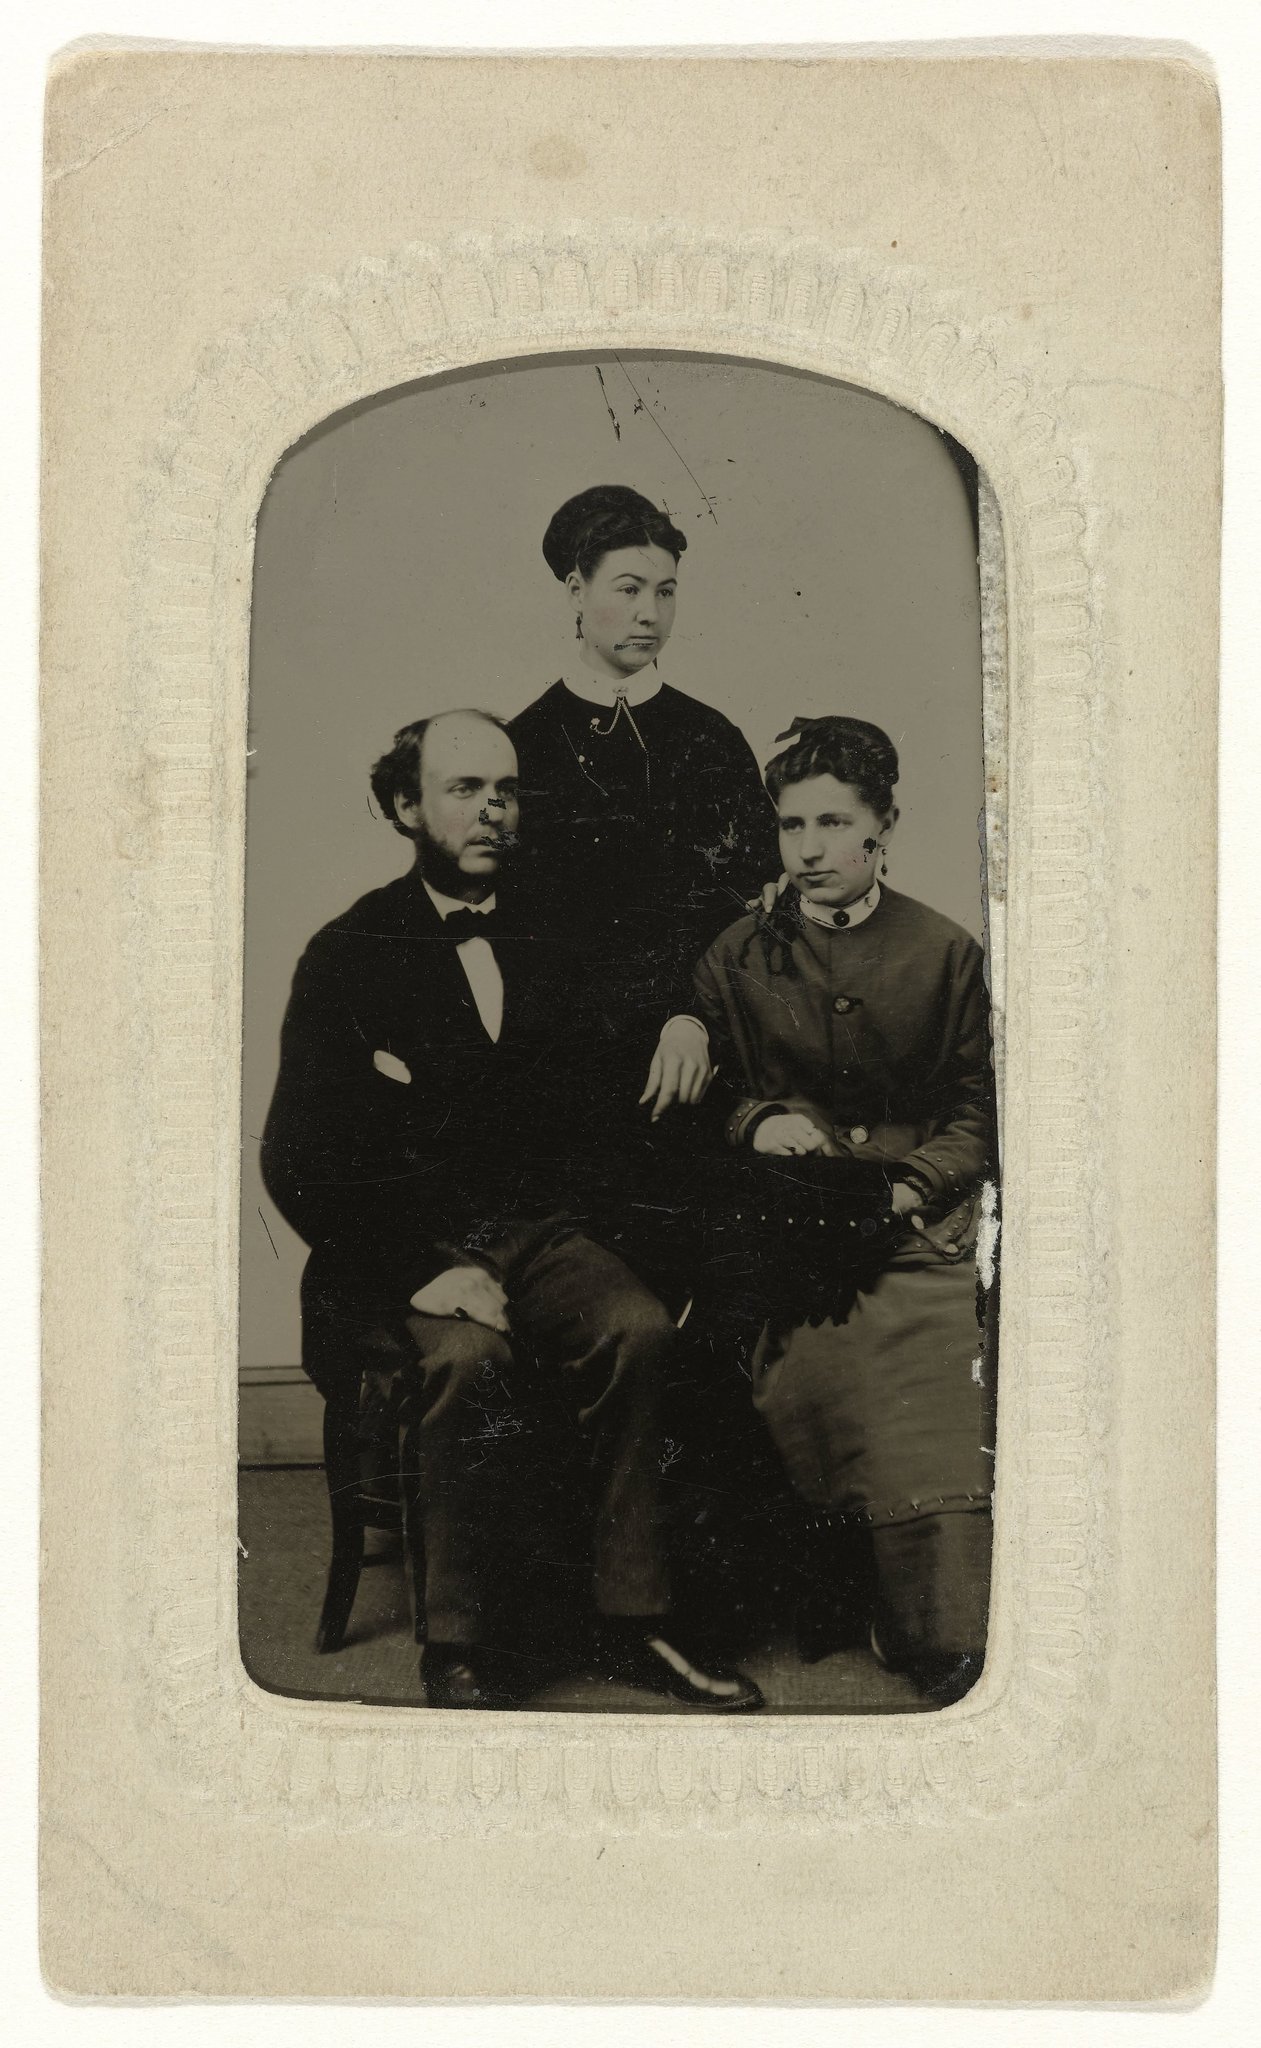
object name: photograph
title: Portret van een man en twee vrouwen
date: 1860-1890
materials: metal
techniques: ferrotyping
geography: united states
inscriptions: annotation: ‘CARD FERROTYPES, / Taken with / PATENT MULTIPLYING CAMERA / only at / Jordan Bro's / FERROTYPE ROOMS, / No. 3 NORTH SALINA, / AND 90 SOUTH SALINA STREET, / Syracuse, N.Y.’